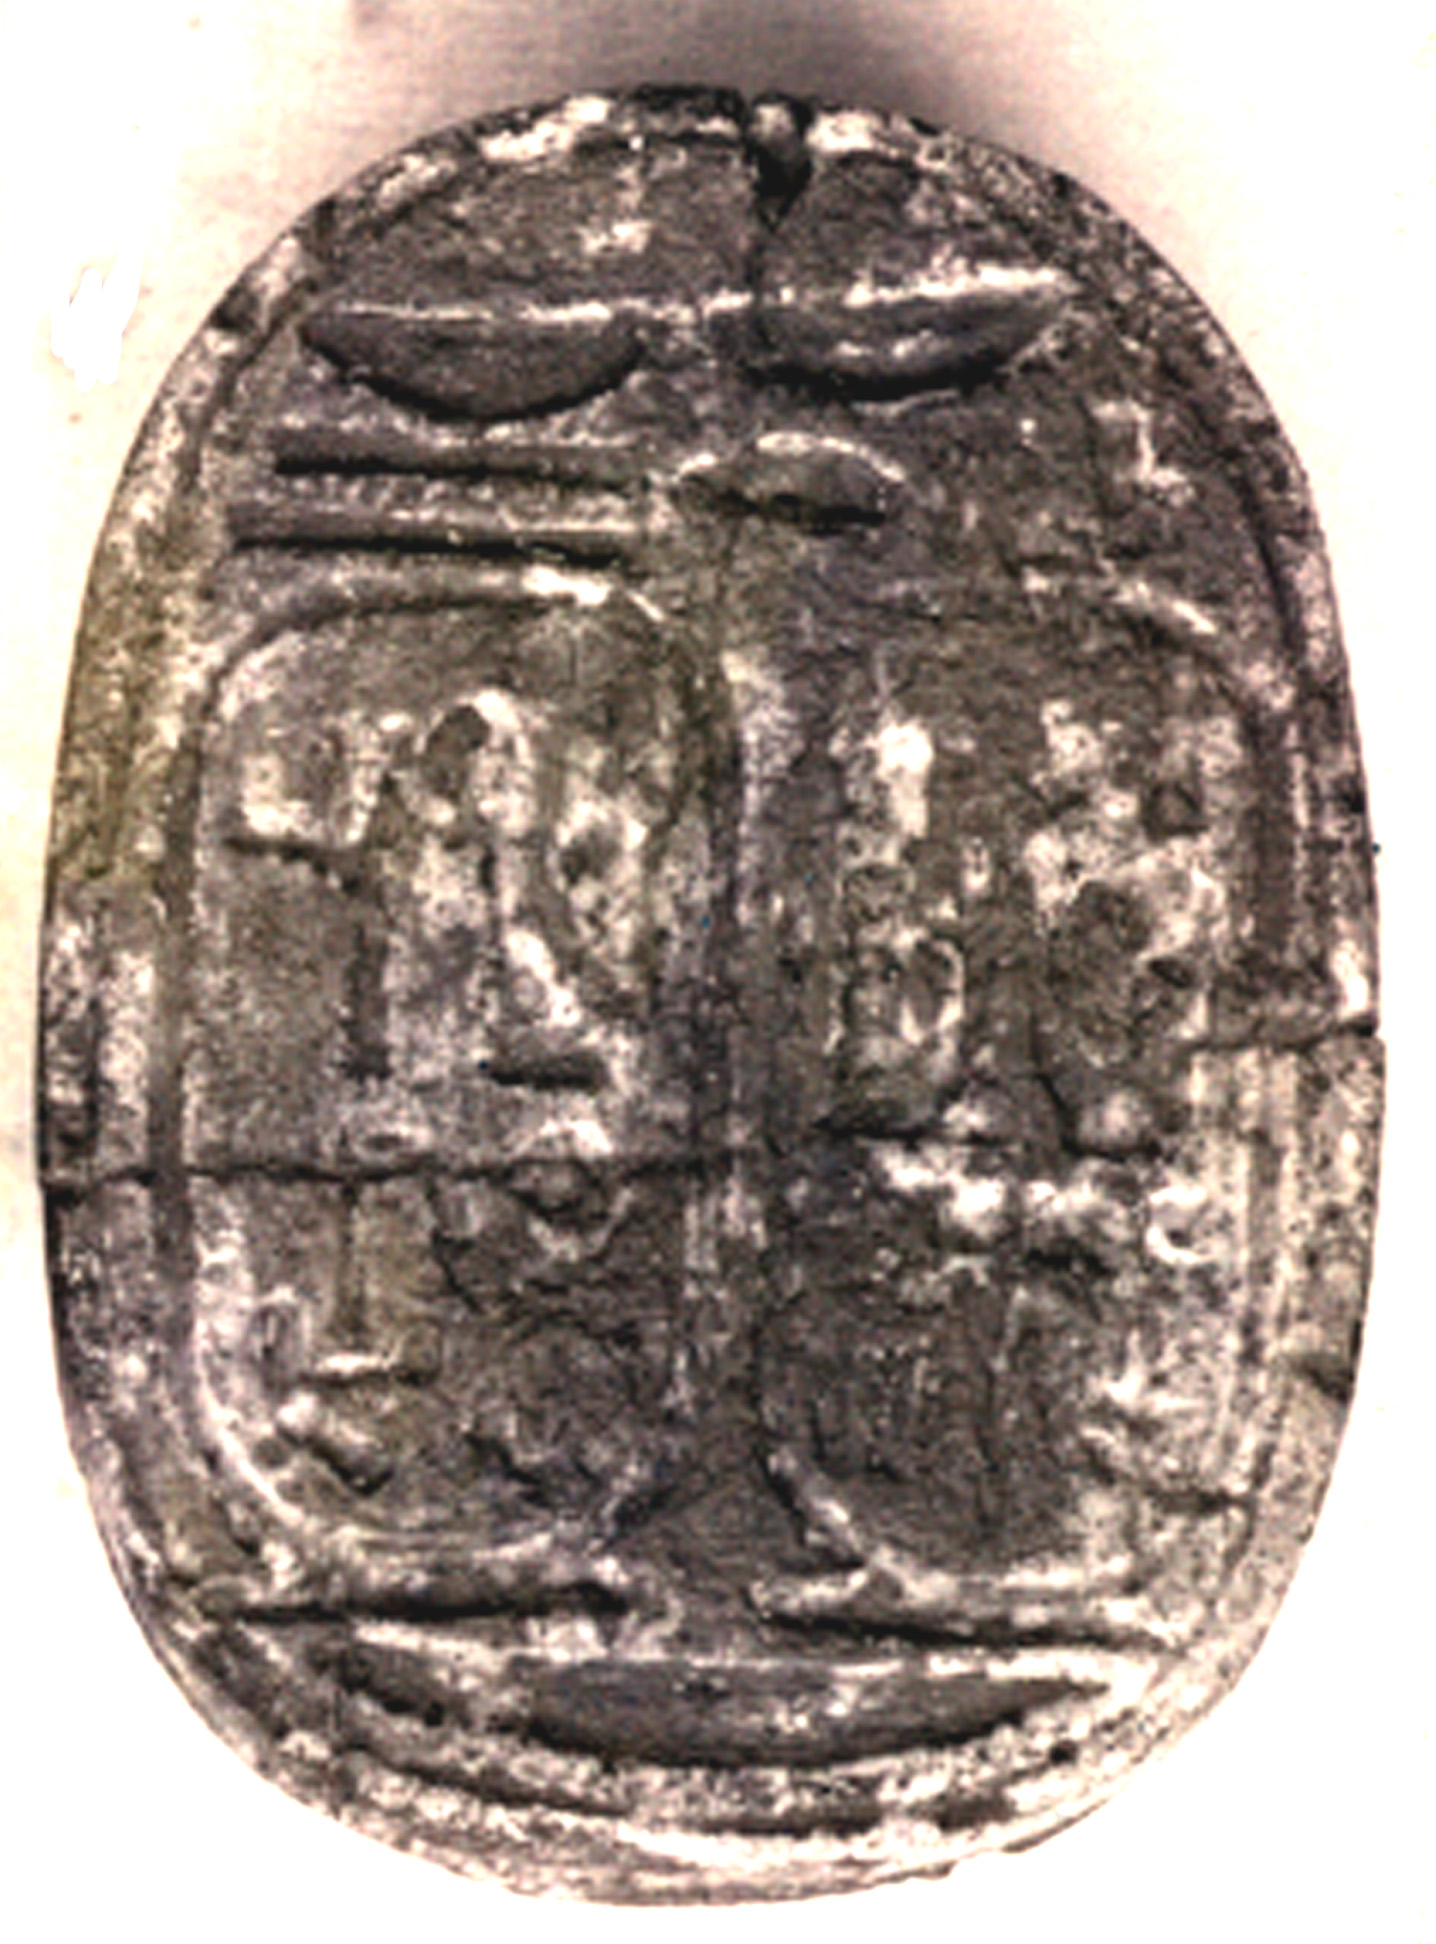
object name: scarab, ramesses ii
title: Scarab Inscribed with the Names of Ramesses II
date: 1295-1186 BCE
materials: faience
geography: egypt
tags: hieroglyphs,scarabs